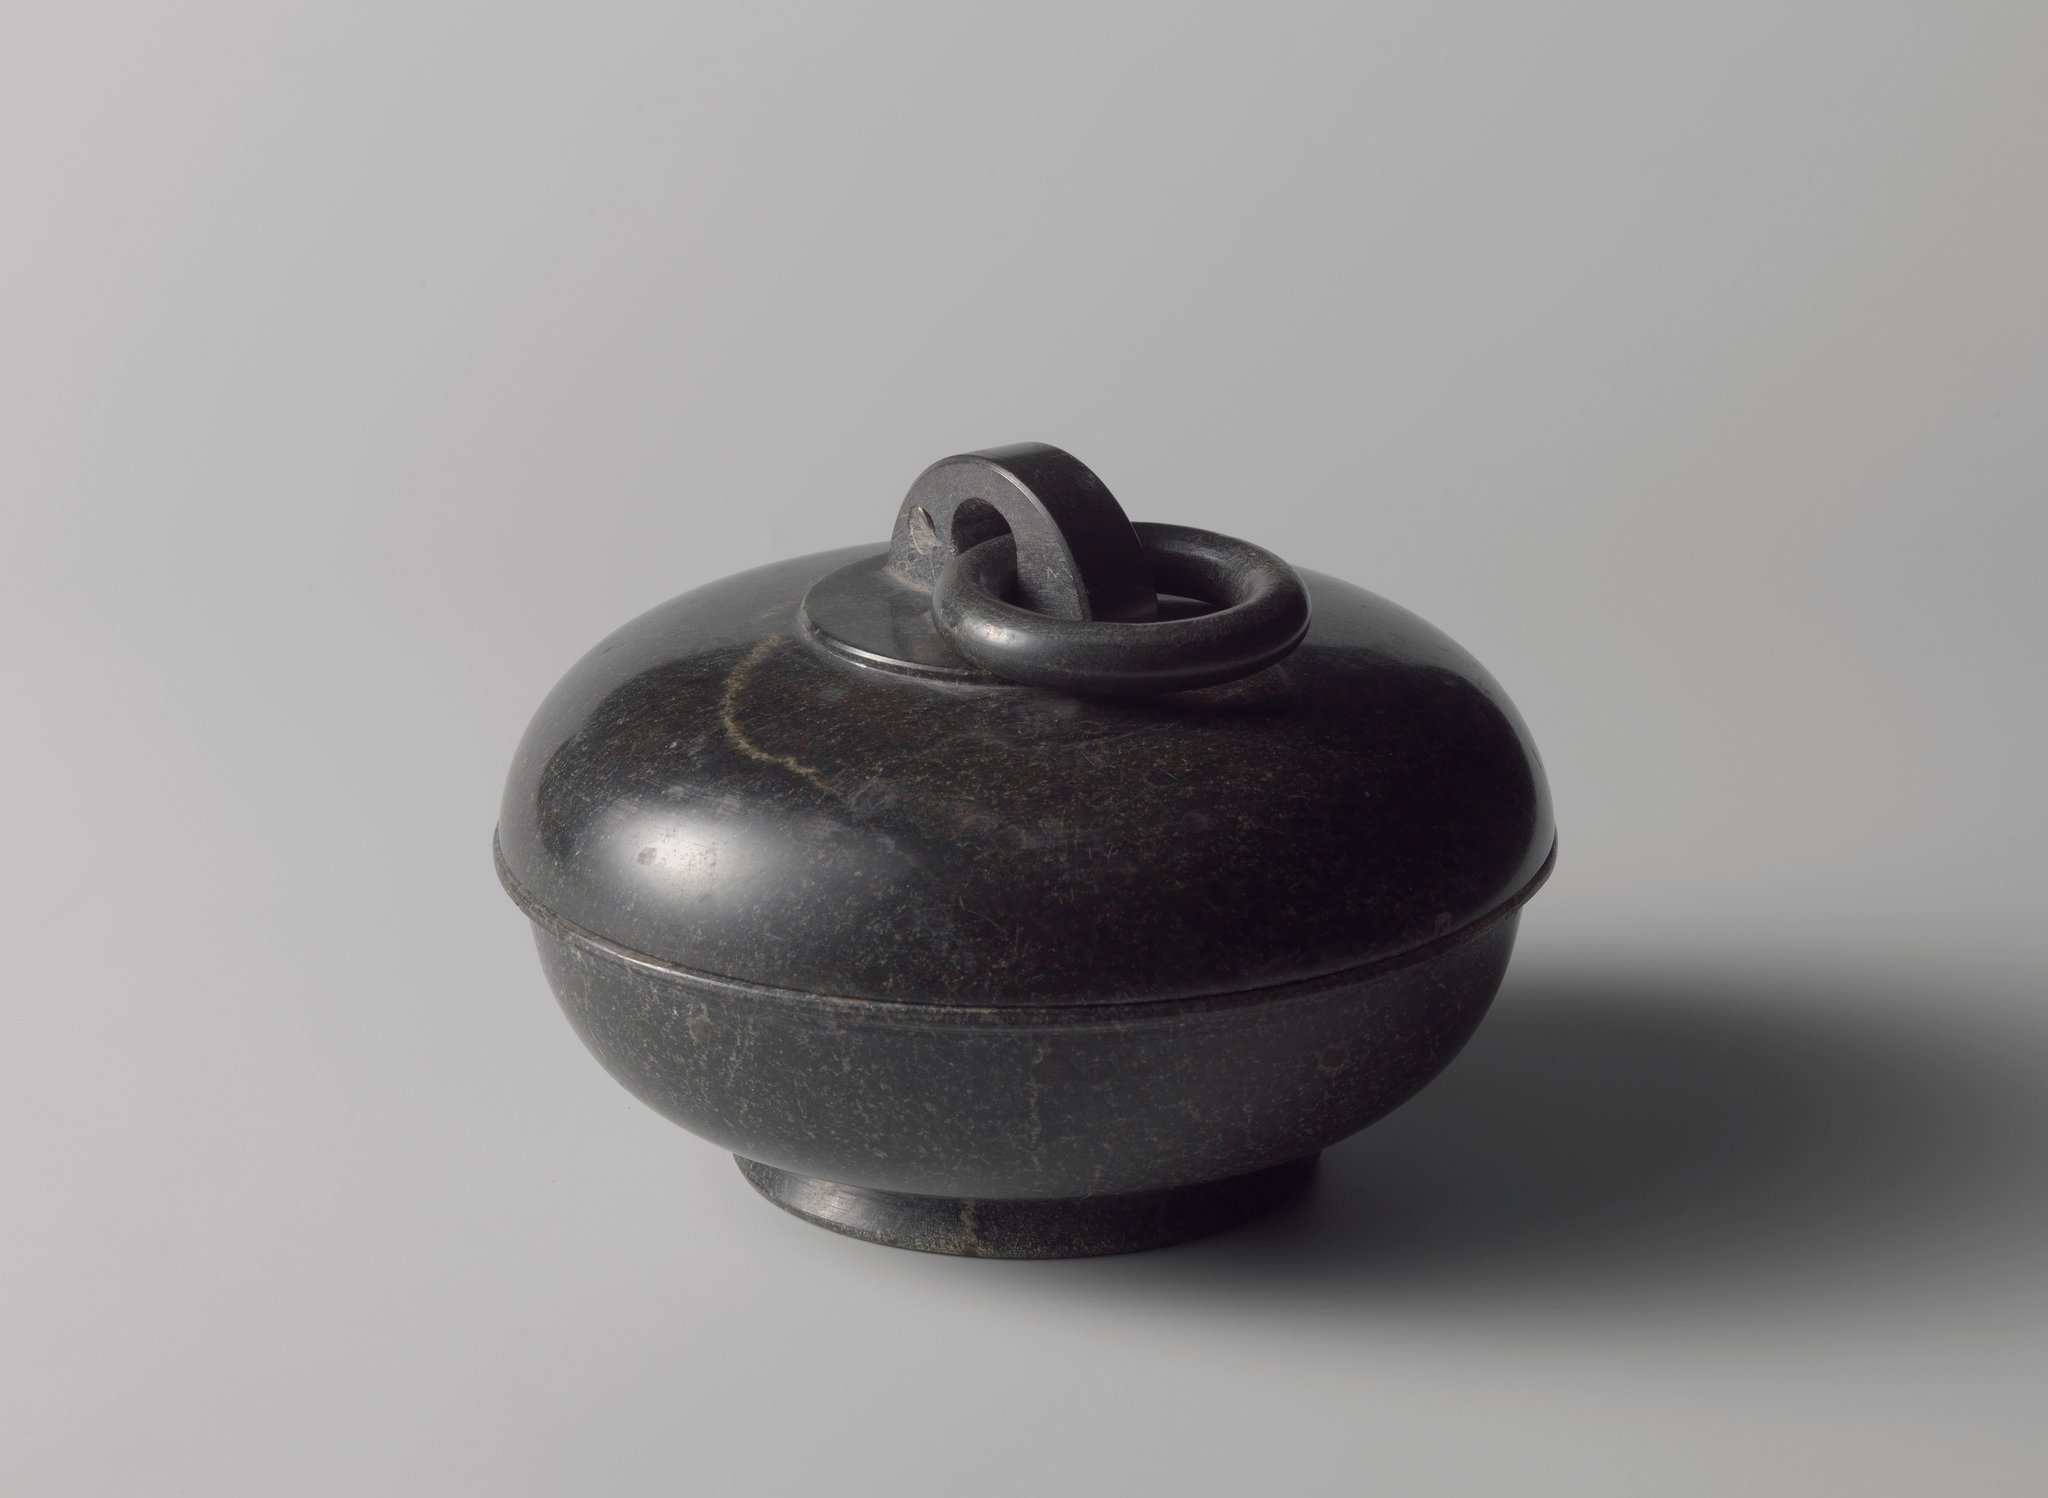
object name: box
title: A Circular Box with a Screw Cover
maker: Anonymous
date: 1600-1650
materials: stone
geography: saxony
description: Ronde doos met schroefdeksel en ring, alles van serpentijnsteen. Onversierd.